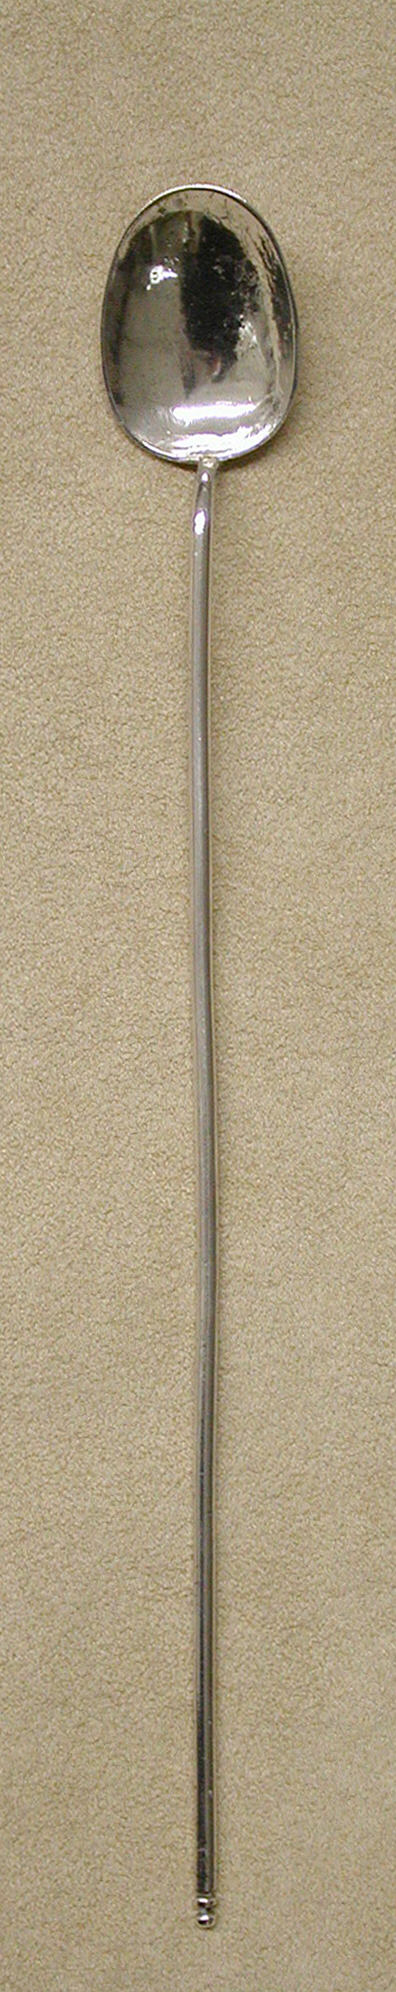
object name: spoon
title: Caudle spoon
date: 1720-1734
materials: silver